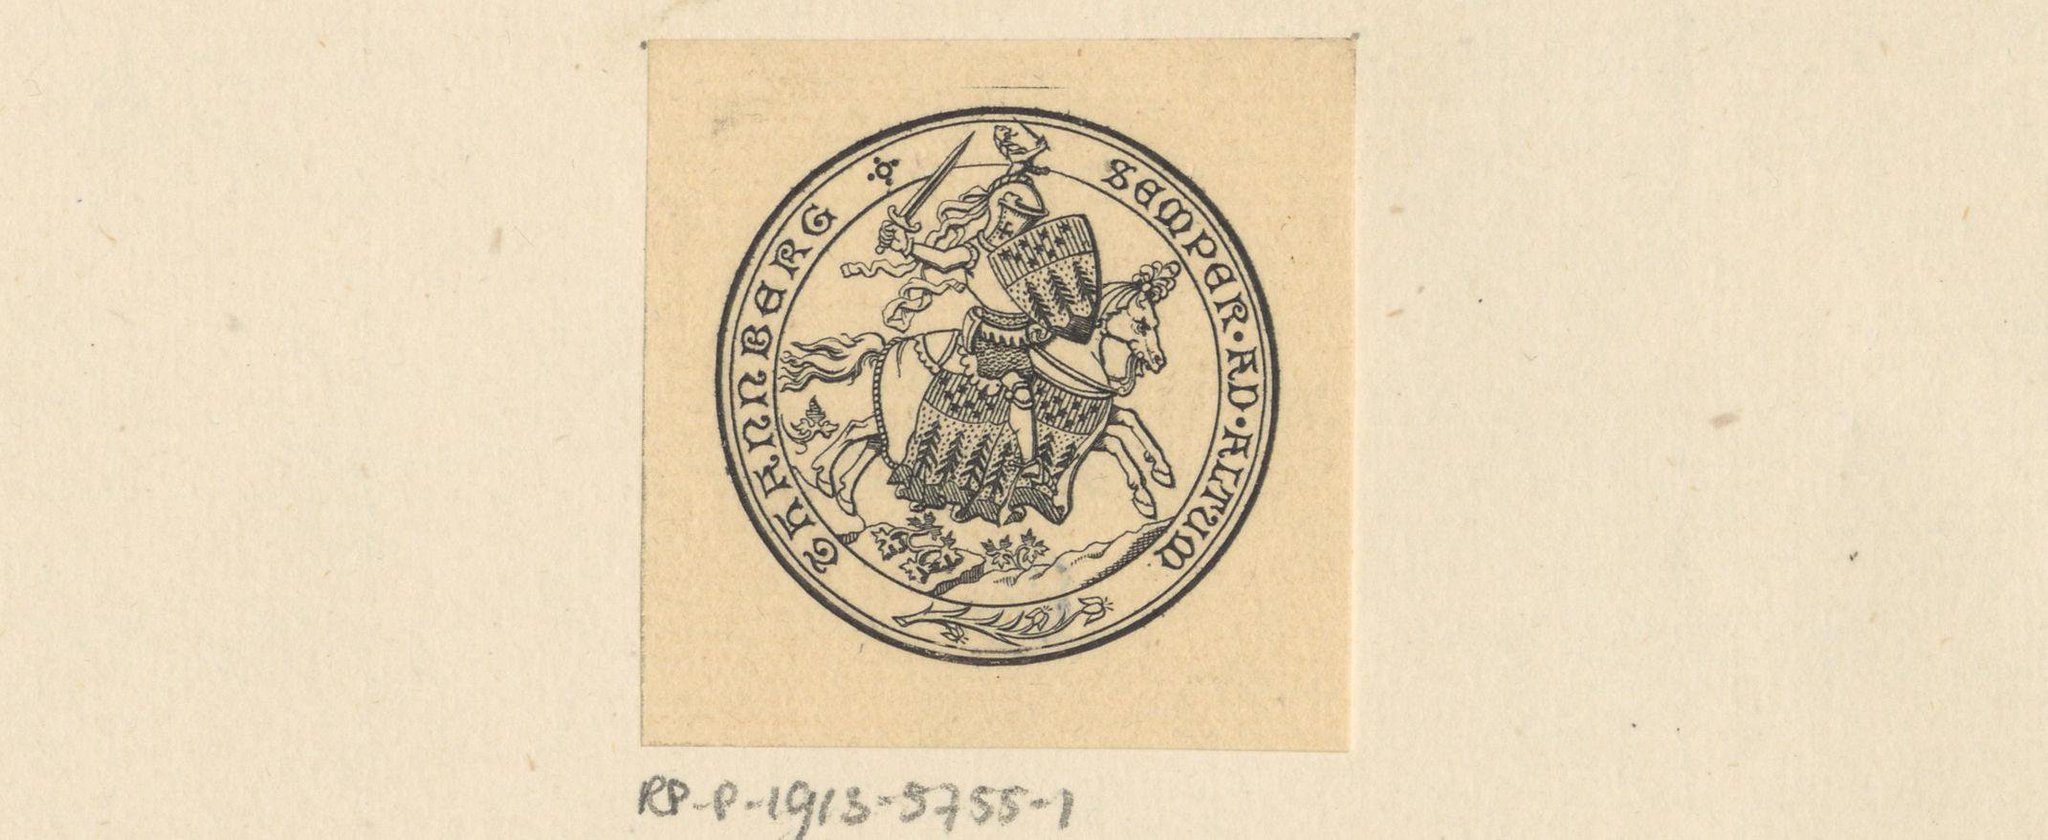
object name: bookplate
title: Ex libris van Tannenberg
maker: Anonymous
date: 1850-1913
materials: paper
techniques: engraving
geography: germany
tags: riding a horse, ass, or mule; rider, horseman, horse, knight, armorial bearing, heraldry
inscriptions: collector's mark: Lugt 2233, collector's mark: Lugt 2760